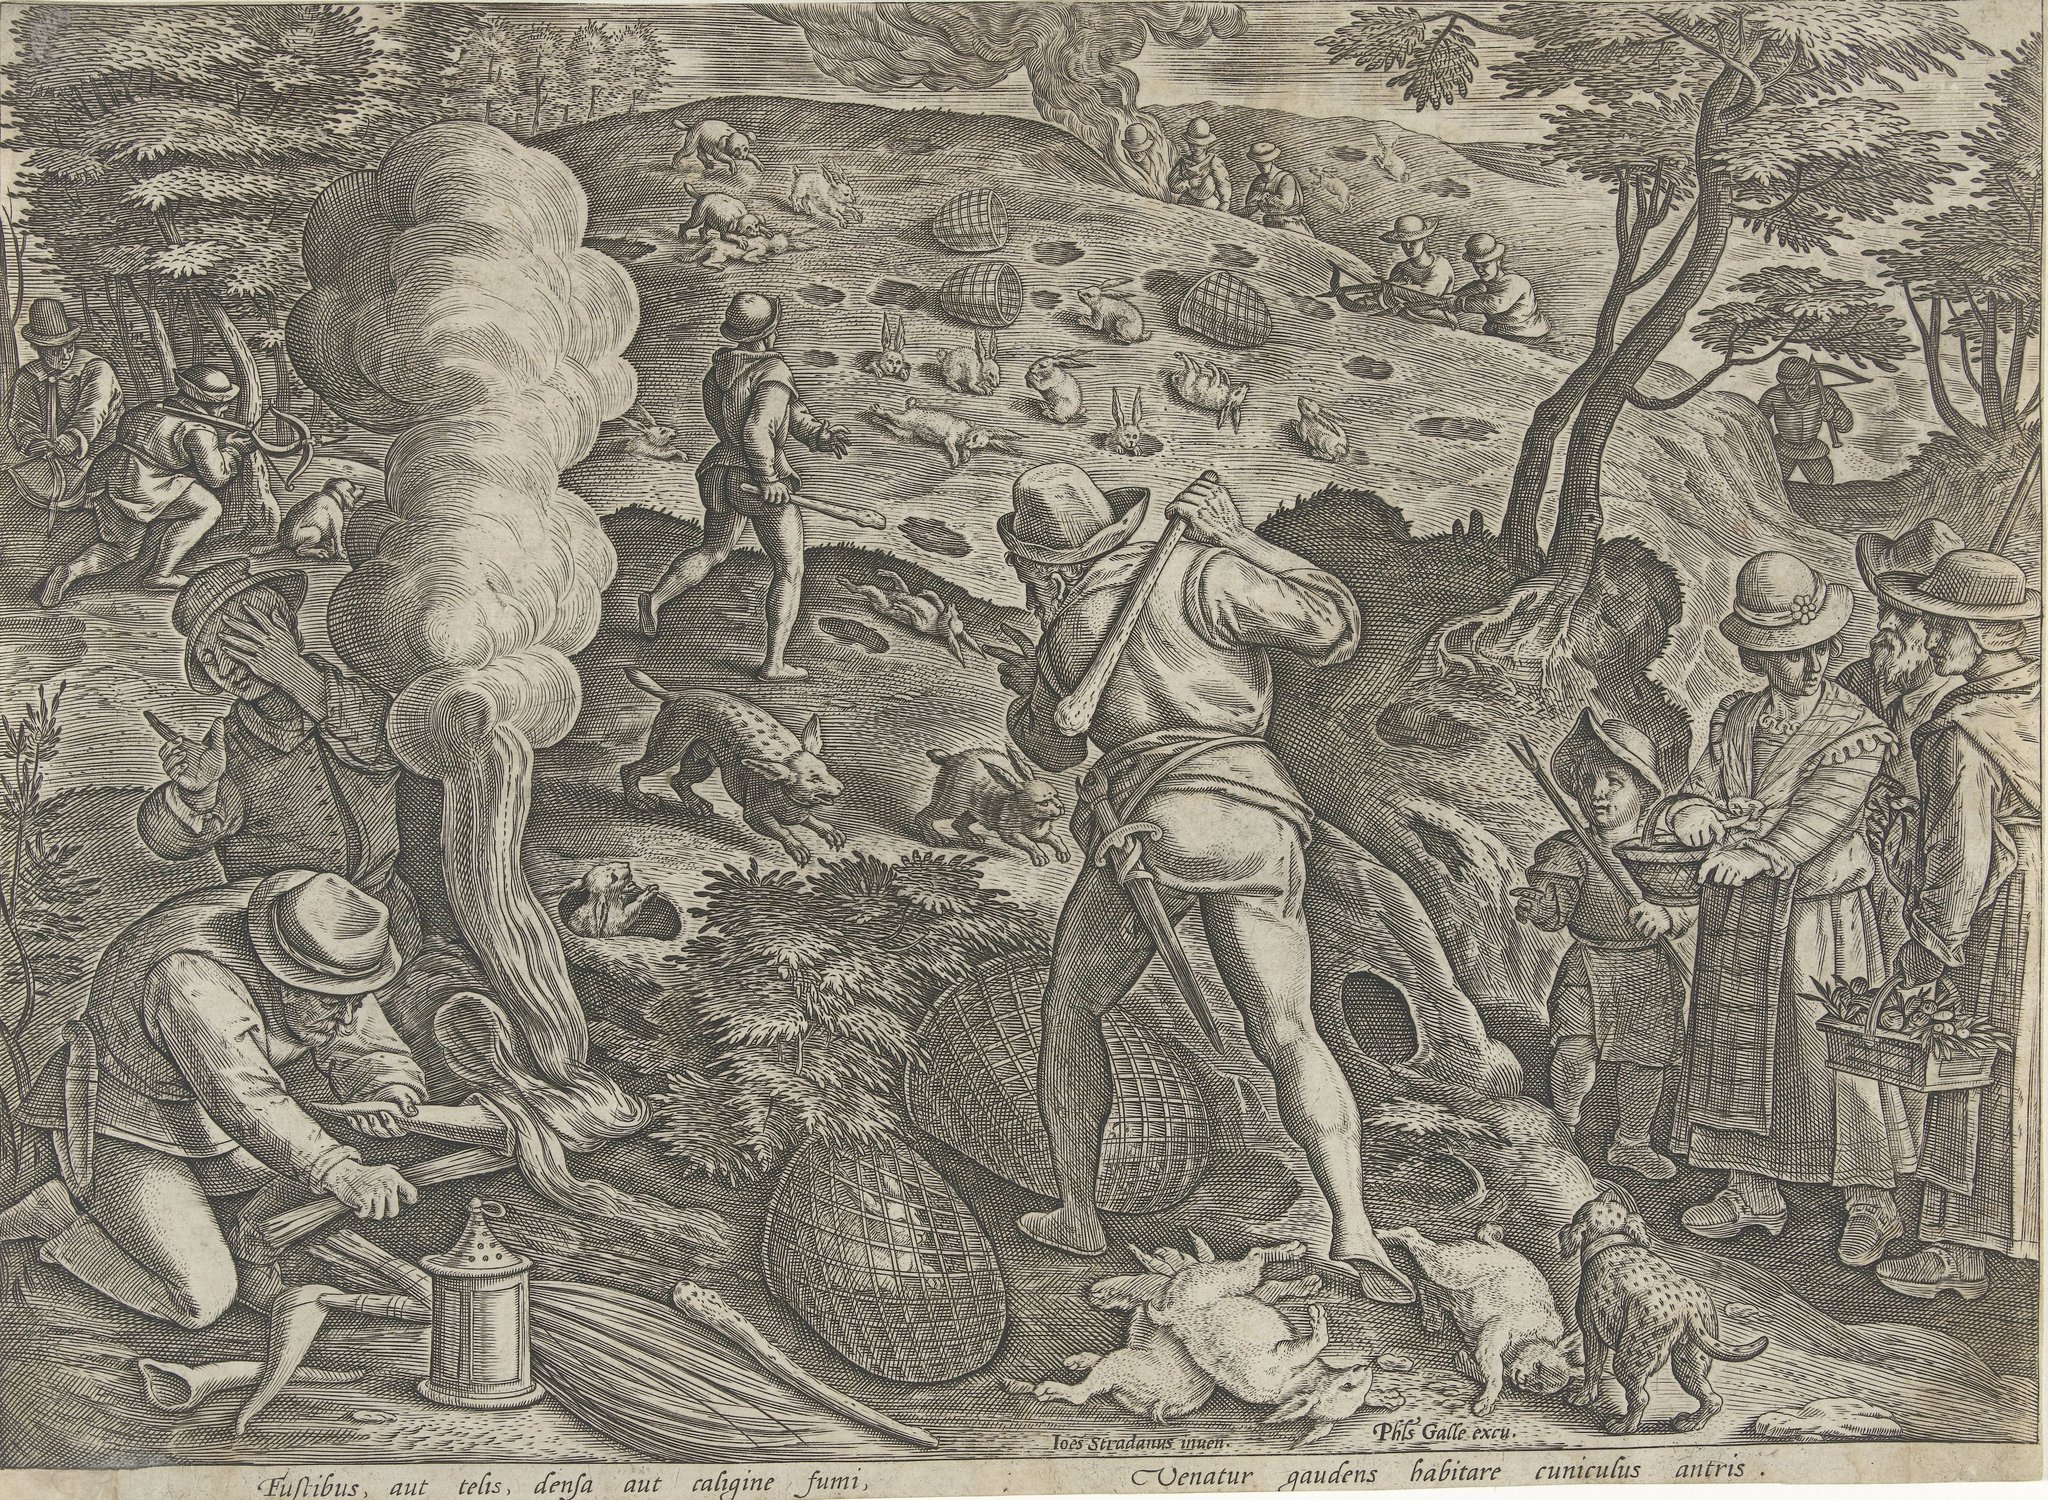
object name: print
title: Jachttaferelen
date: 1578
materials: paper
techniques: engraving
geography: florence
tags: hare-hunting, rabbit-hunting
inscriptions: collector's mark: Lugt 2228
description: Konijnen worden met rook uit hun holen gejaagd, waarna ze door jagers in fuiken worden gevangen en worden doodgeslagen. De prent heeft een Latijns onderschrift en maakt deel uit van een 43-delige serie over de jacht.